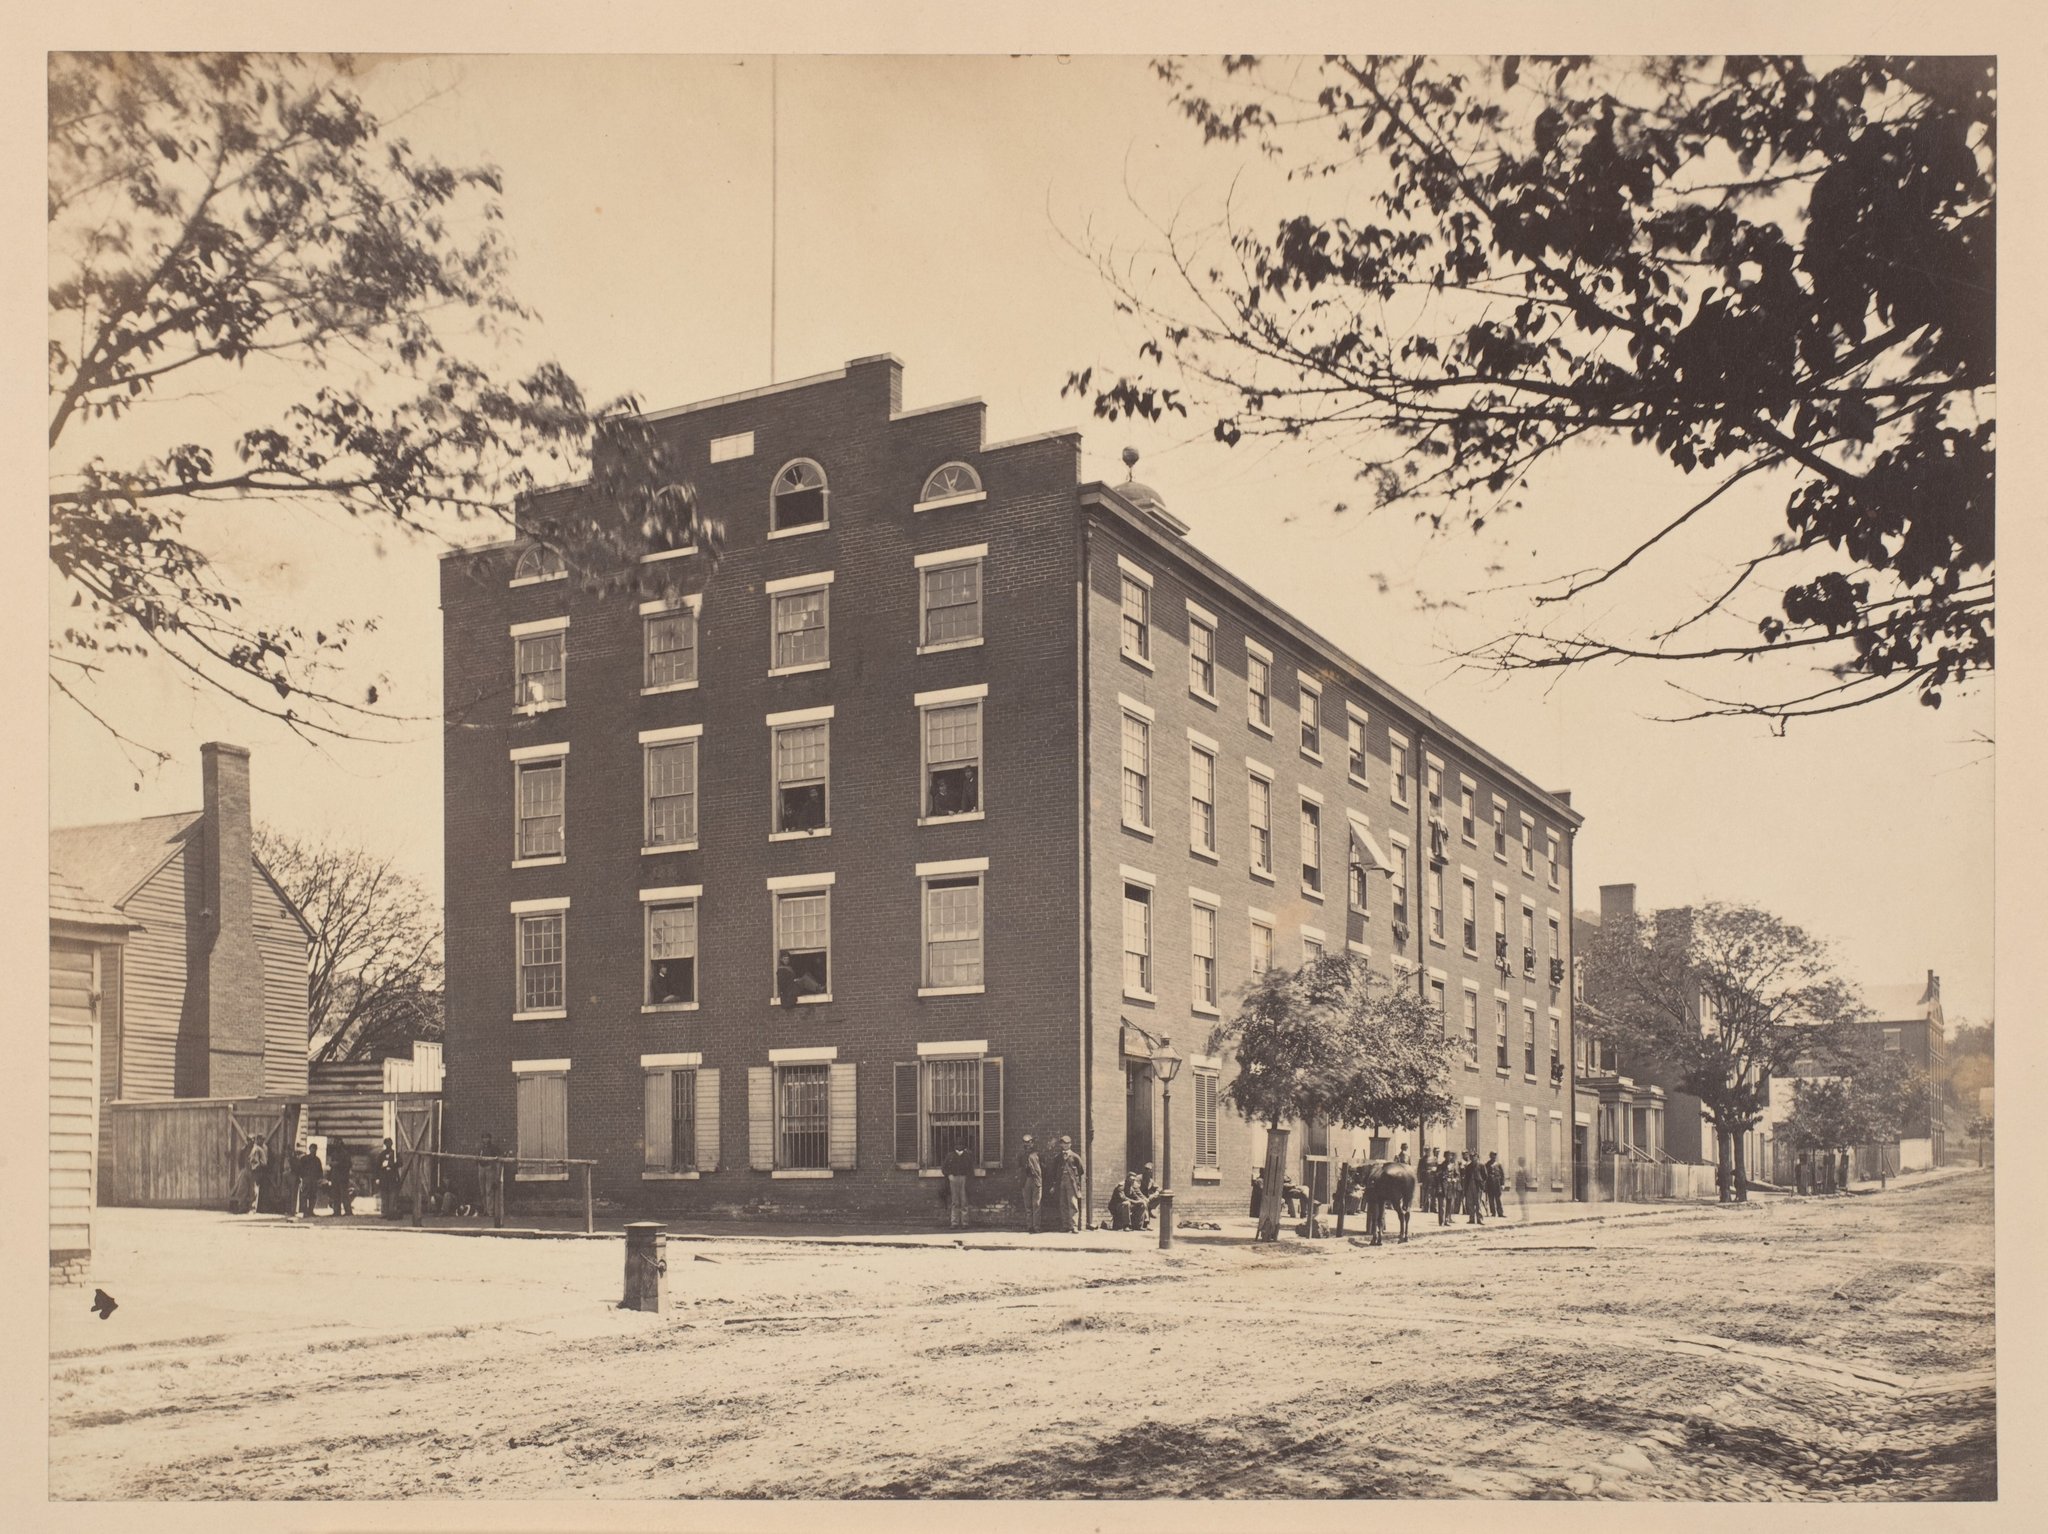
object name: photograph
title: [Civil War View]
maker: thomas c. roche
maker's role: artist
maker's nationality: american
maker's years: 1826-1895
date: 1860-1869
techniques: albumen silver print, glass negative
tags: buildings,american civil war